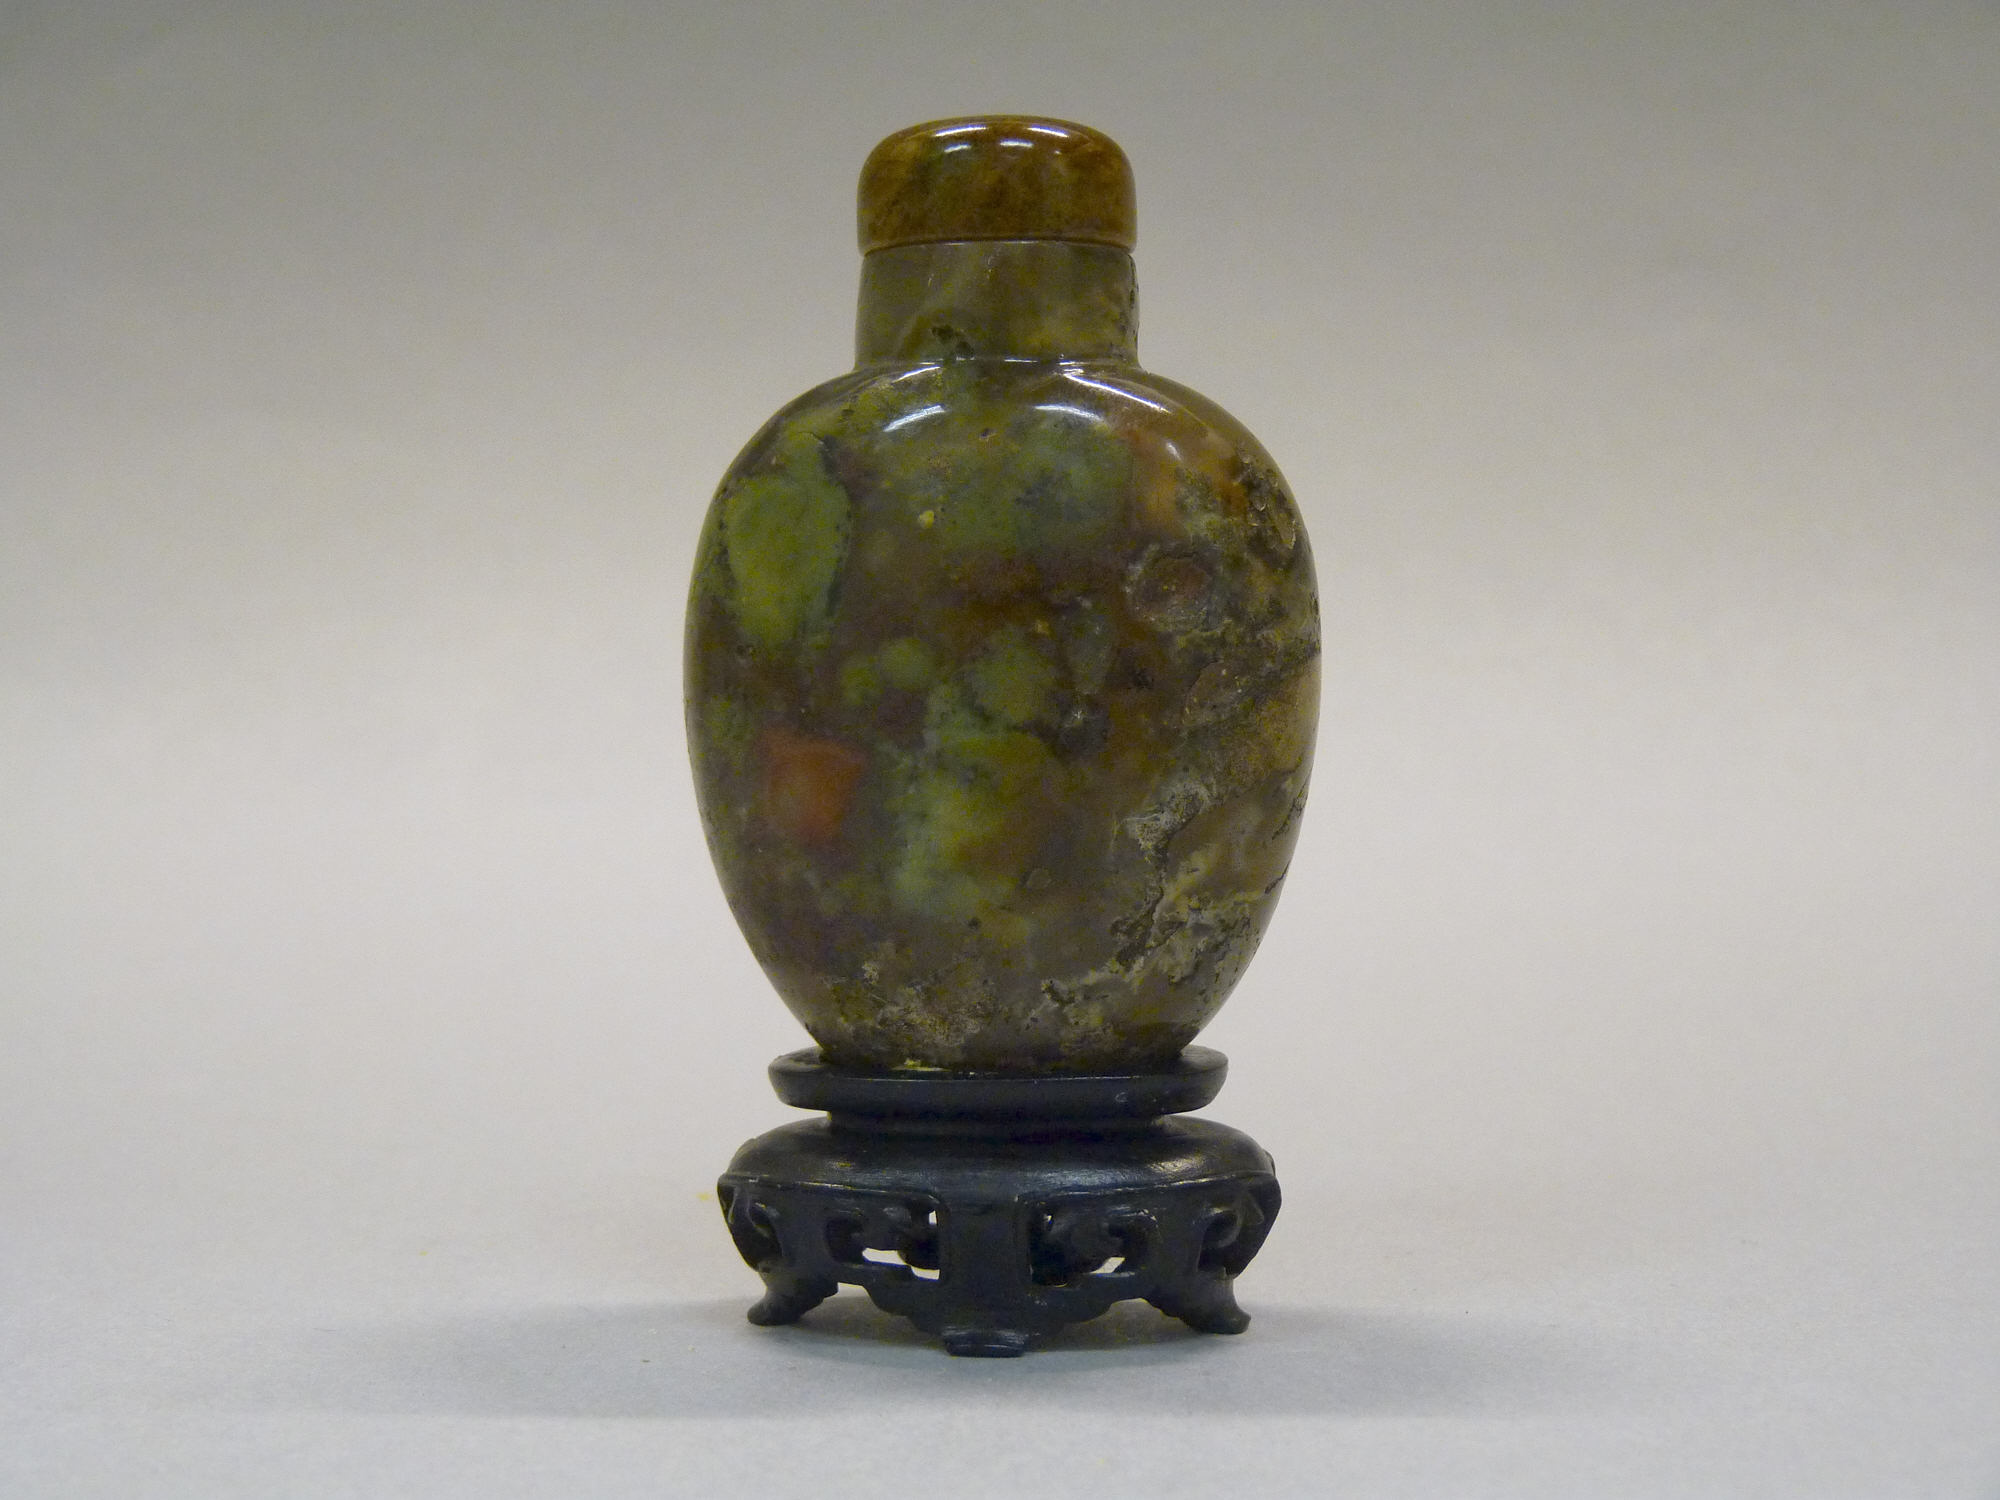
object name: snuff bottle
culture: chinese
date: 1736-1795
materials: stone